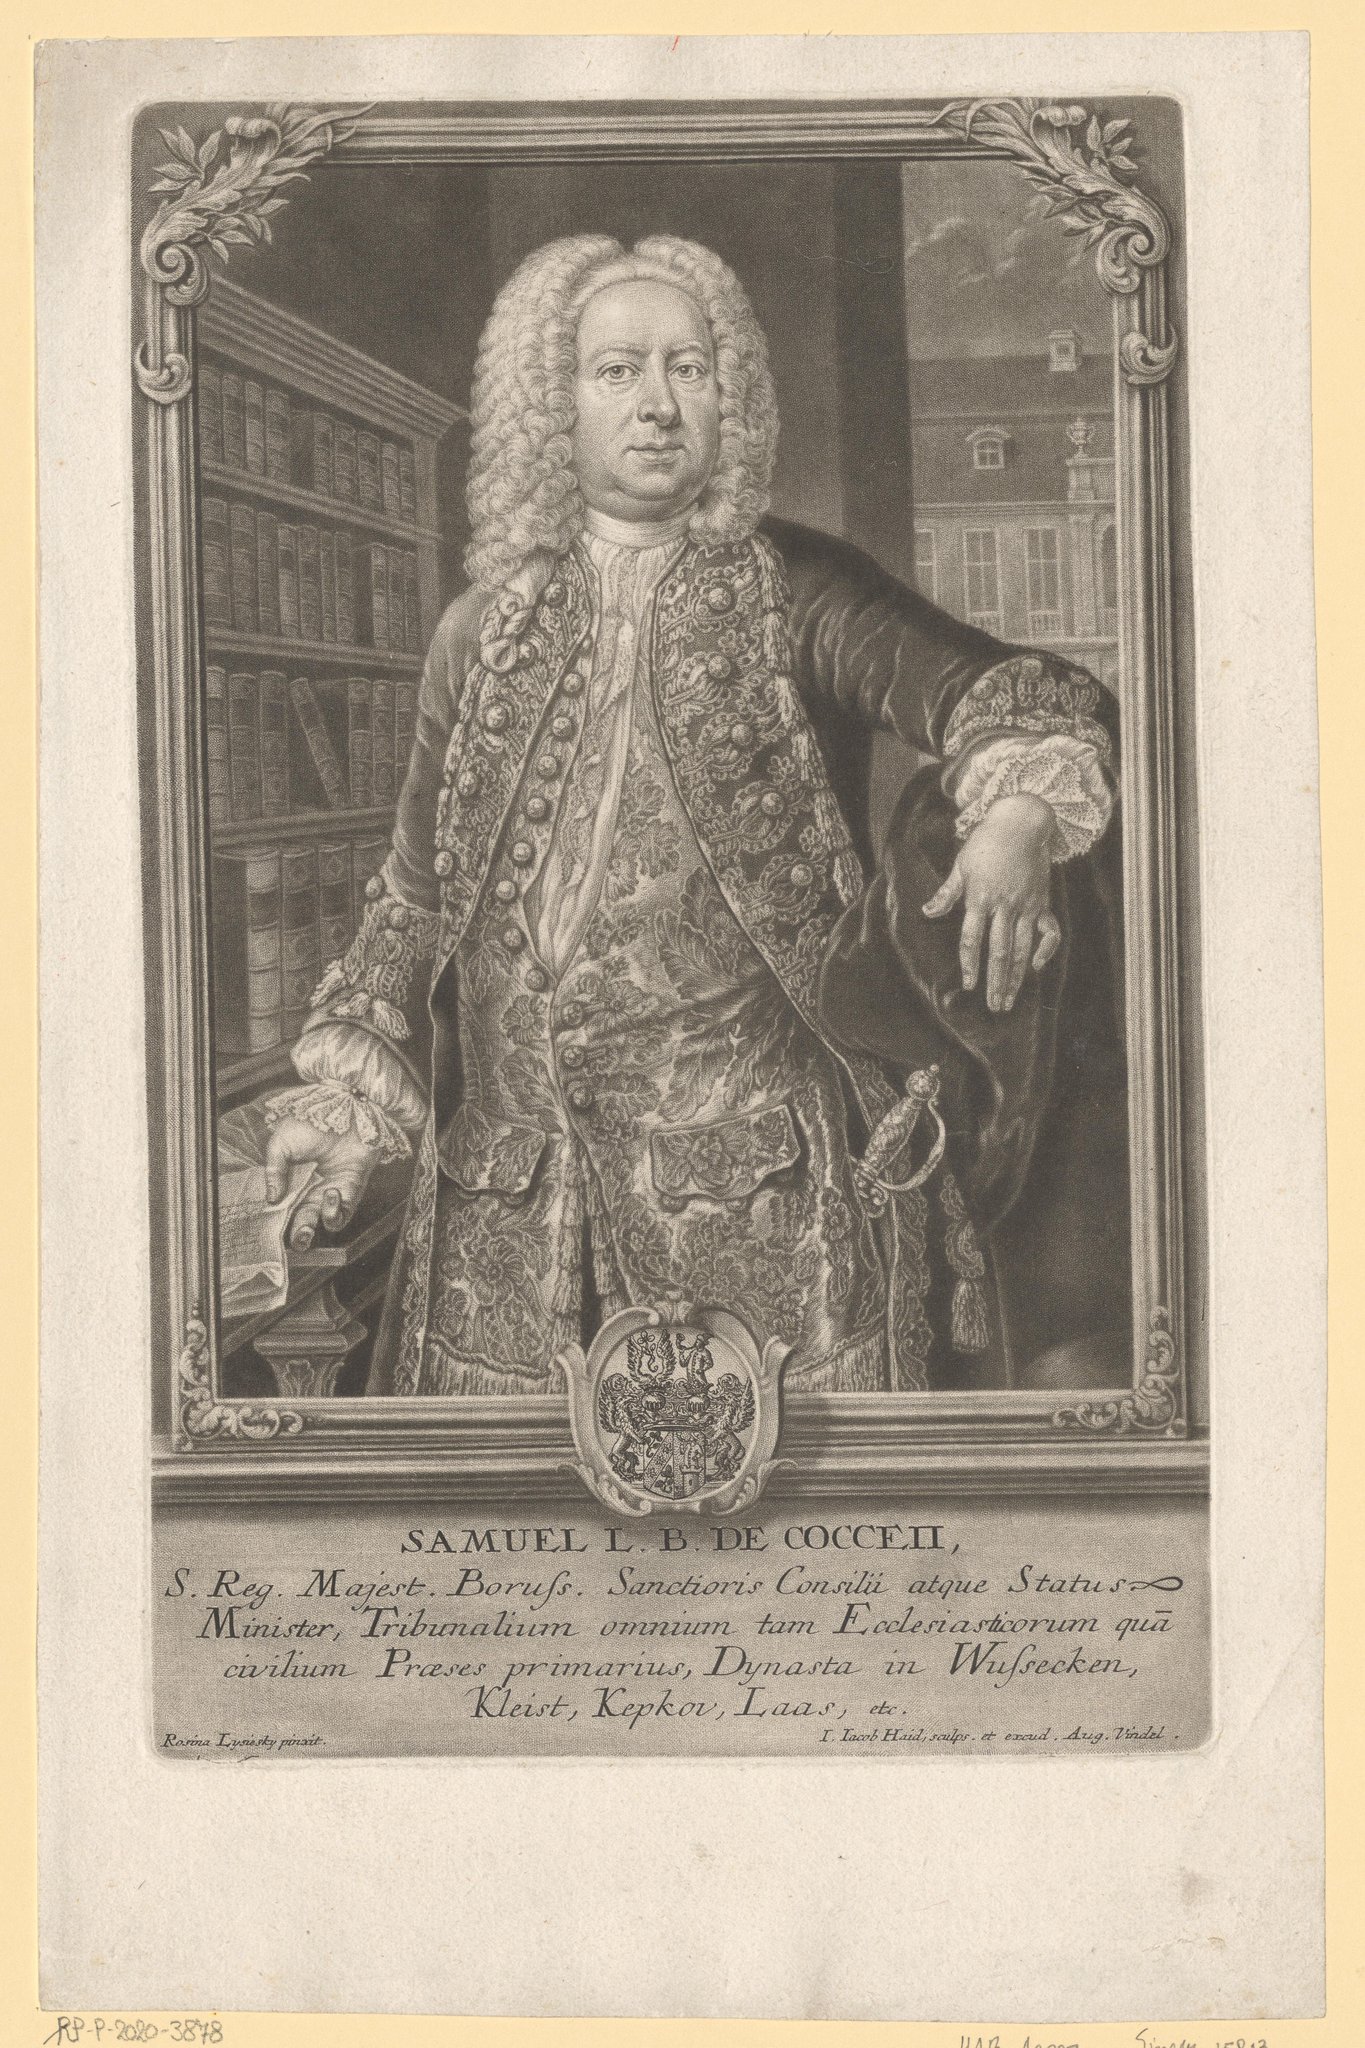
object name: print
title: Portret van Samuel Freiherr von Cocceius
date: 1737-1767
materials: paper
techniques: etching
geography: augsburg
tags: berlin, bookcase, with doors, historical persons